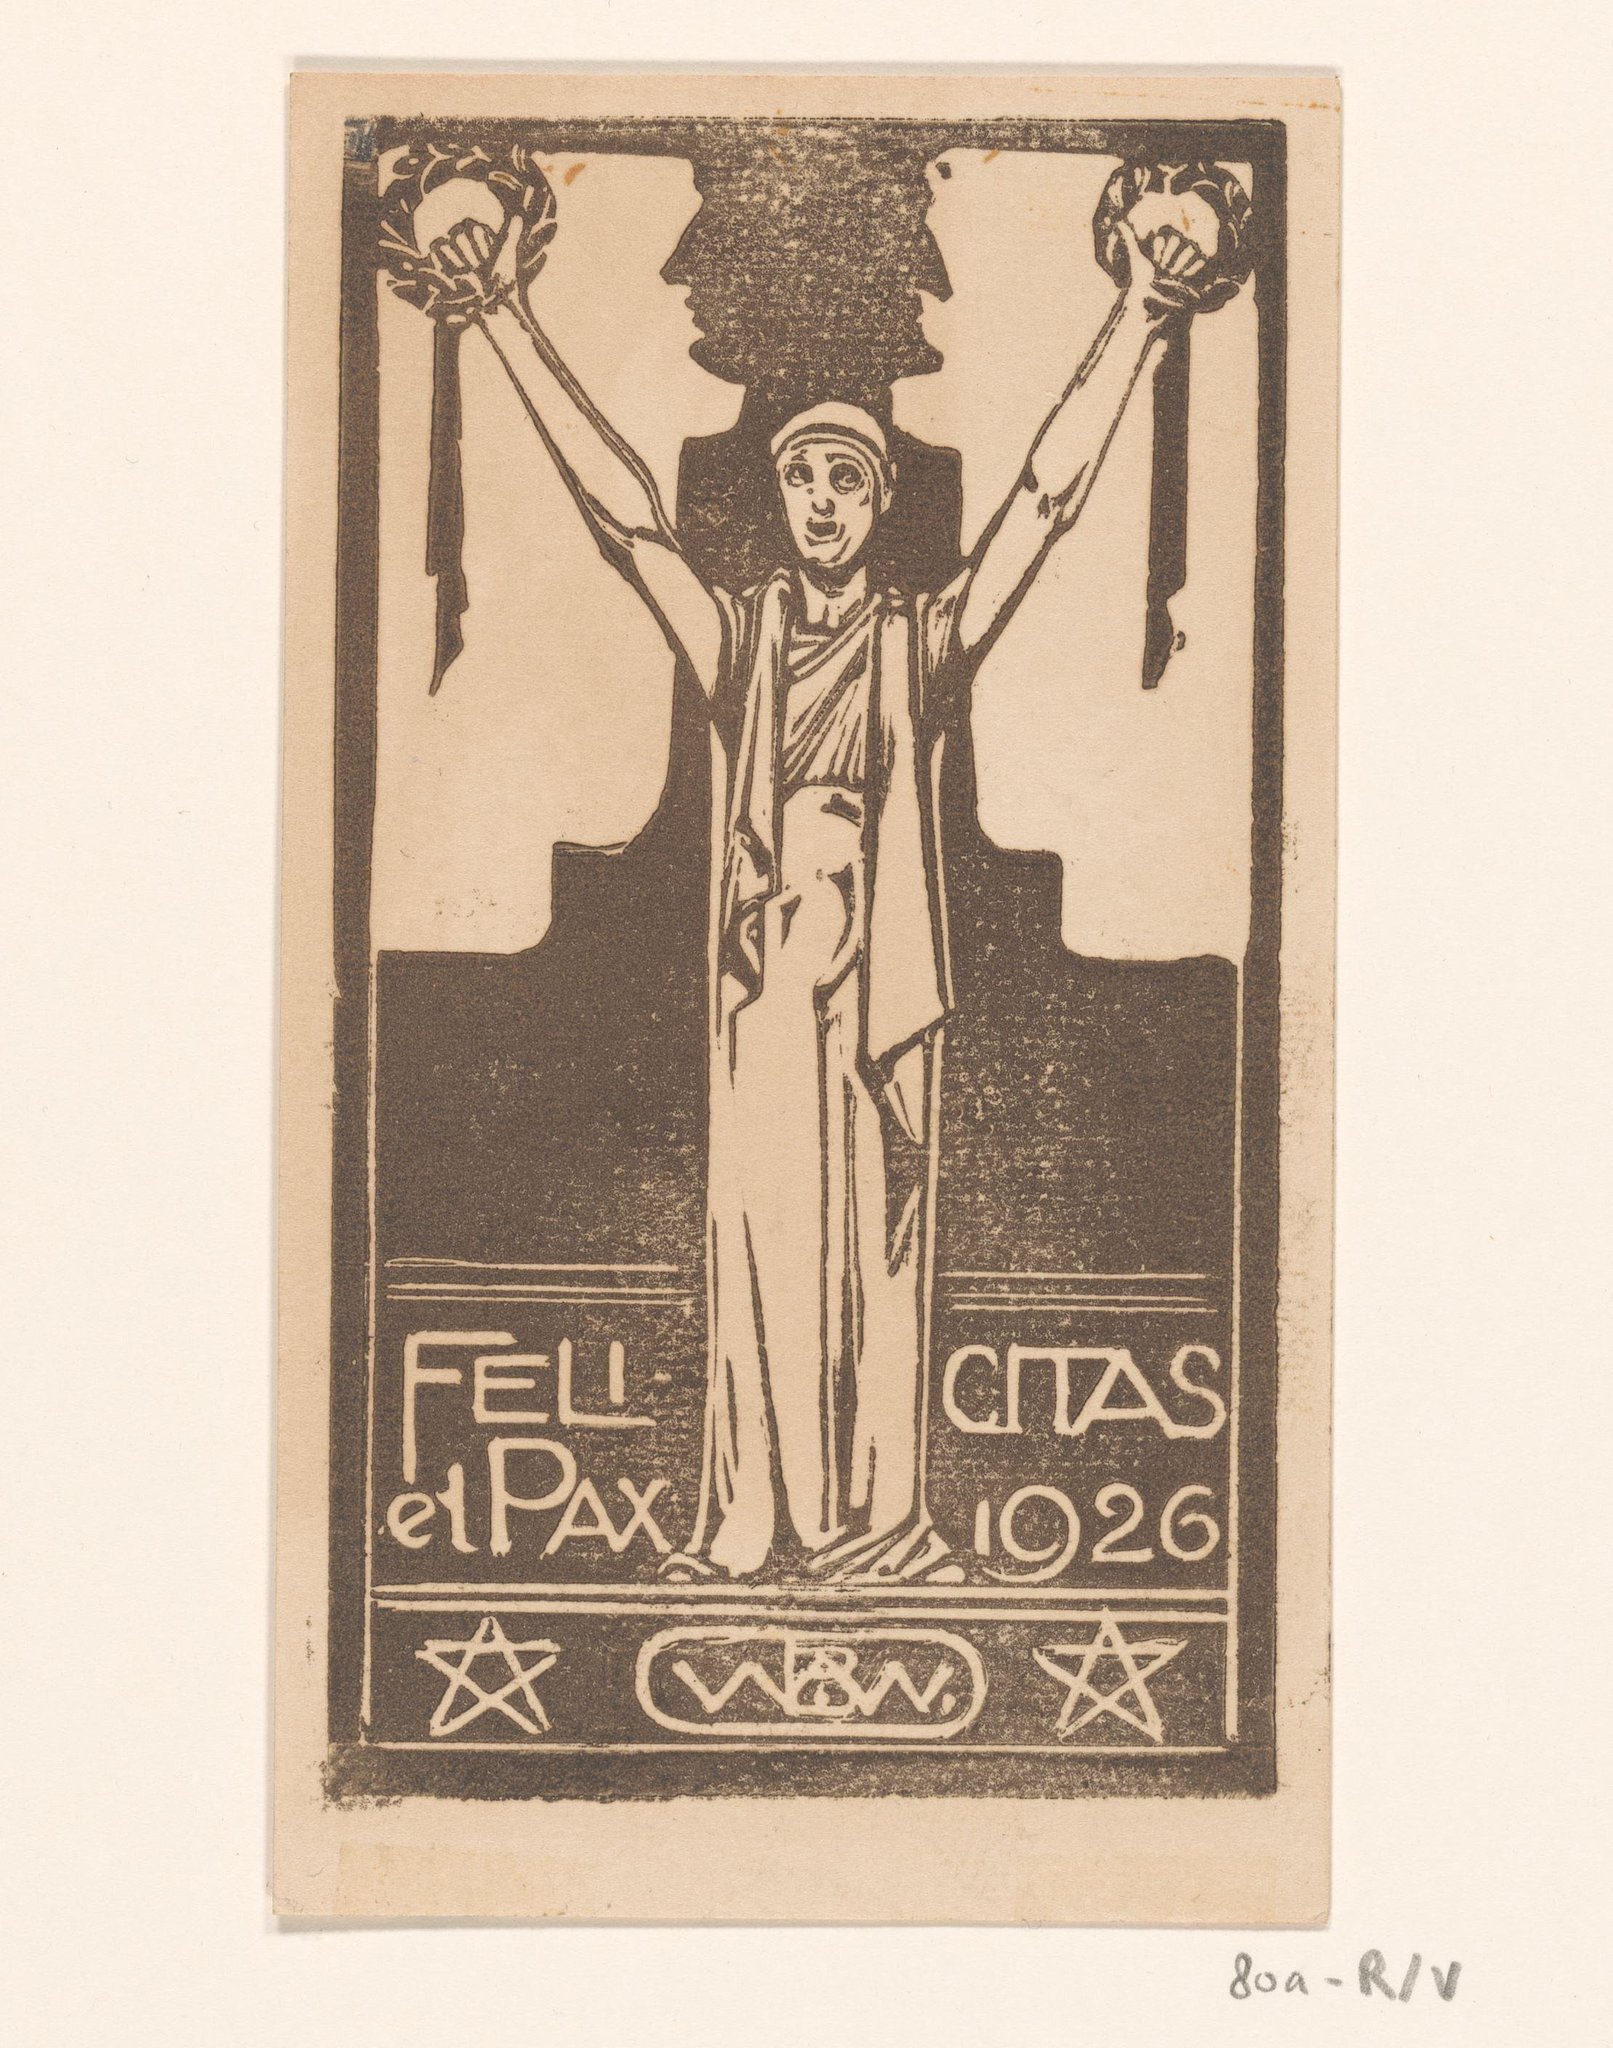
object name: print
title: Felicitas et Pax 1926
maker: bernard willem wierink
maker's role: draughtsman, print maker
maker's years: 1856-1939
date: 1926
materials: paper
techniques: relief print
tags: symbols, allegories of peace, 'pax'; 'pace' (ripa)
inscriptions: date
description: Deze prent is vermoedelijk een plaatsnede, ook al wordt in de literatuur veelal gesproken over een houtsnede. Voor zover Wierink zijn prenten in hoogdruk zelf nader heeft omschreven, heeft hij altijd de term 'plaatsnede' gebruikt.